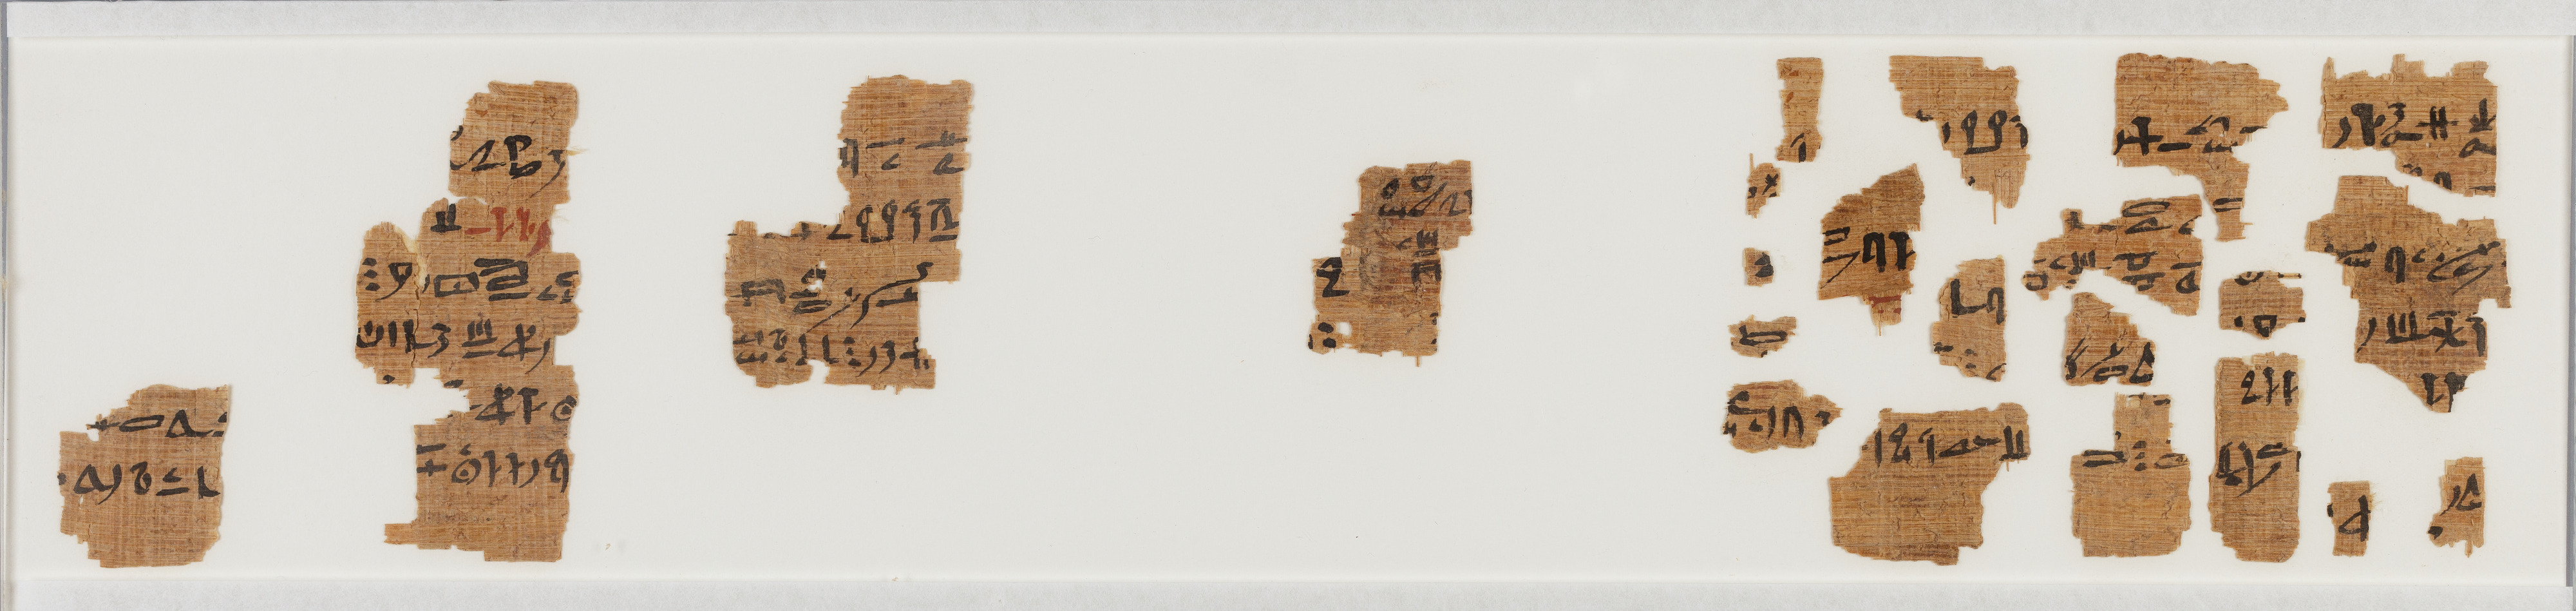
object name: papyrus, funerary, book of the dead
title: Book of the Dead, fragments of chapters 23 and 26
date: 1186-712 BCE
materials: ink, papyrus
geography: egypt